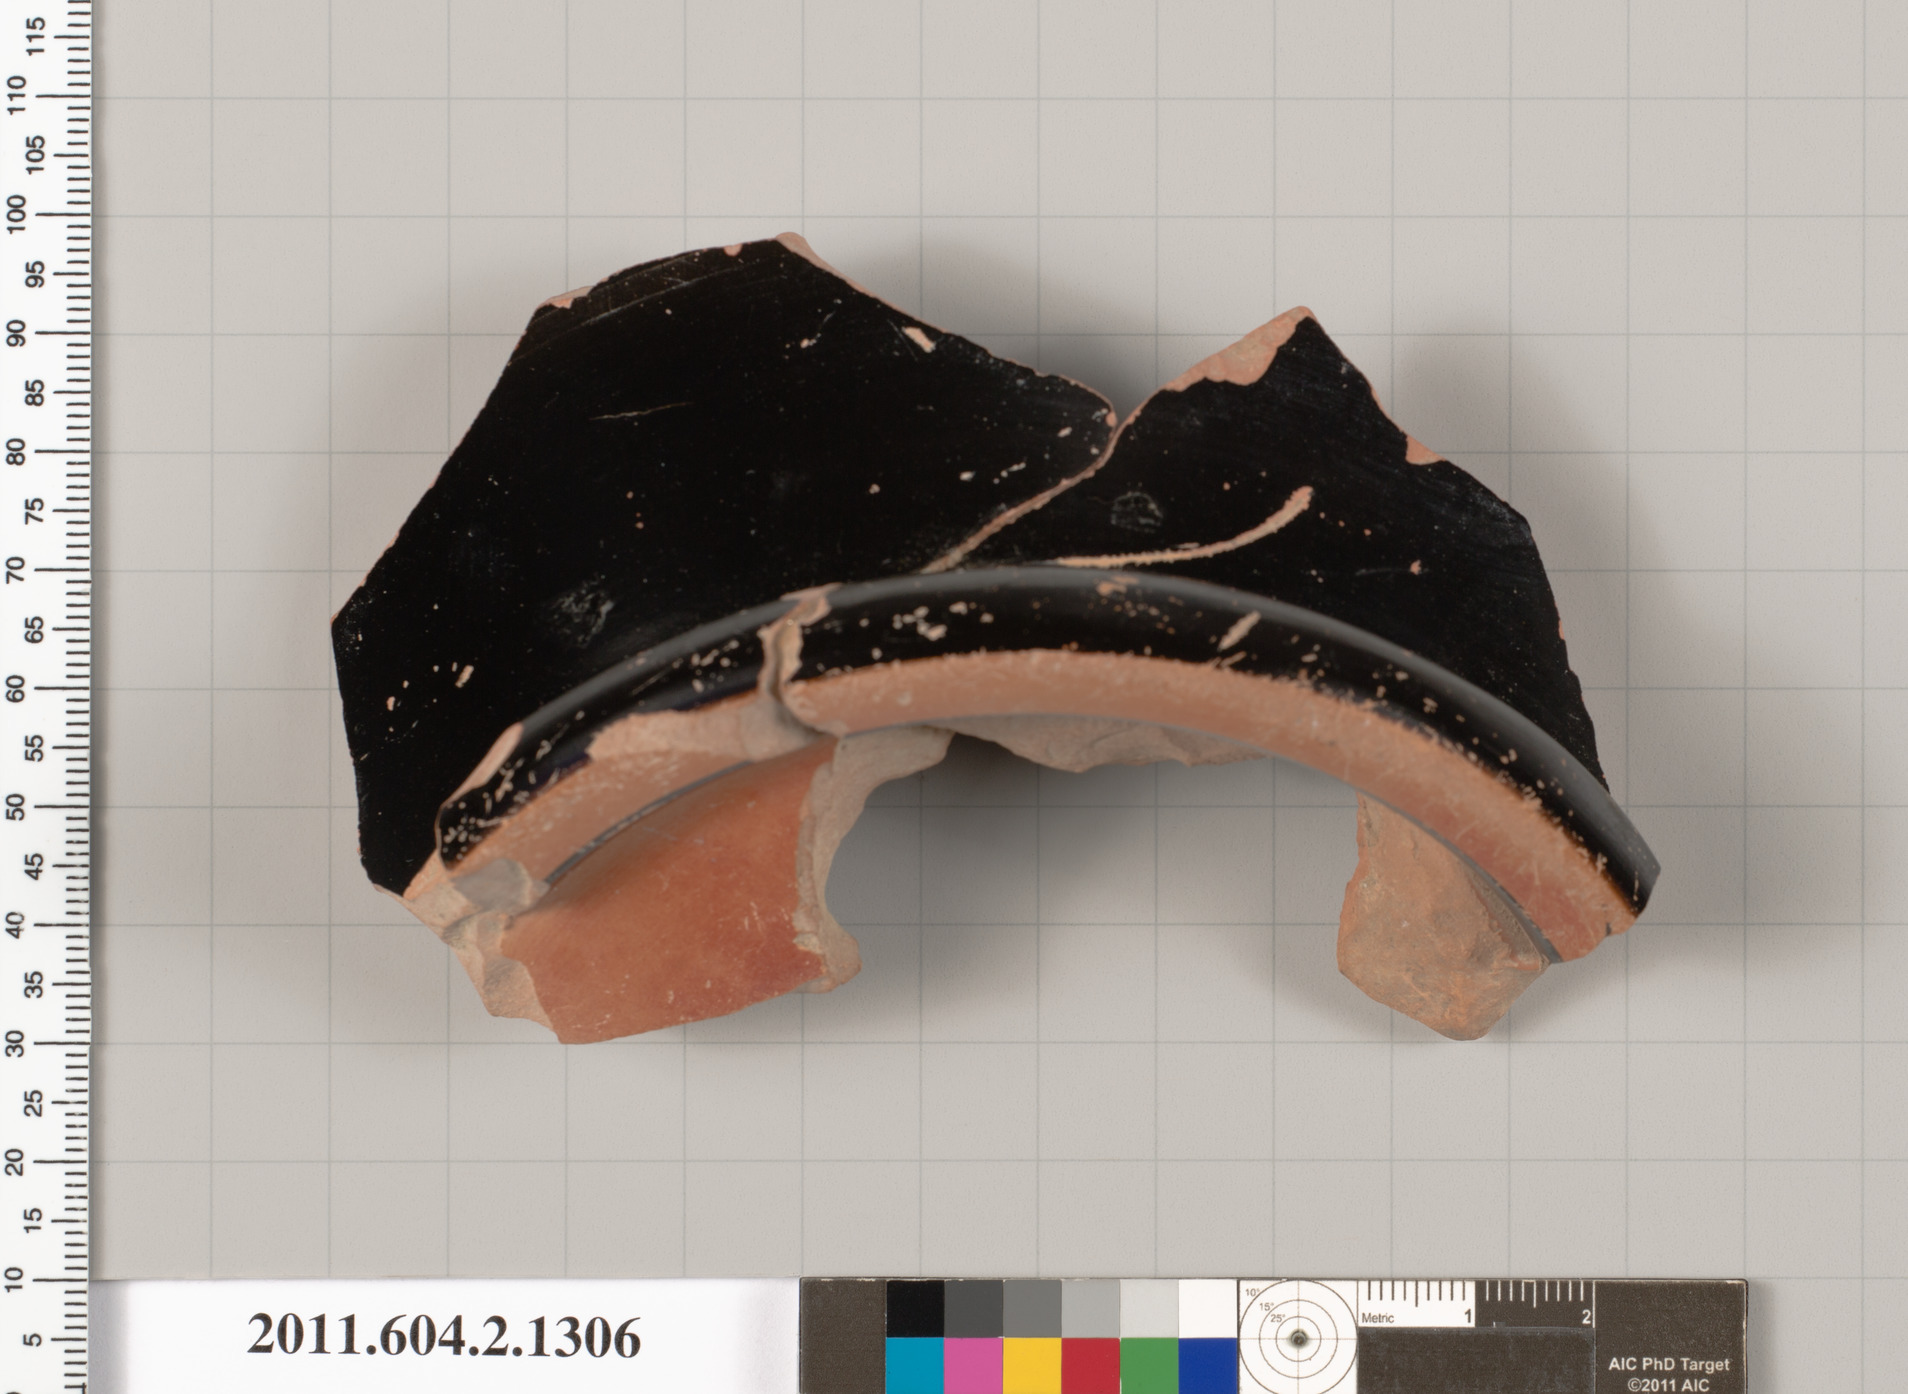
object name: skyphos fragment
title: Terracotta fragment of a skyphos (deep drinking cup)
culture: greek, attic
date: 500-451 BCE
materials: terracotta